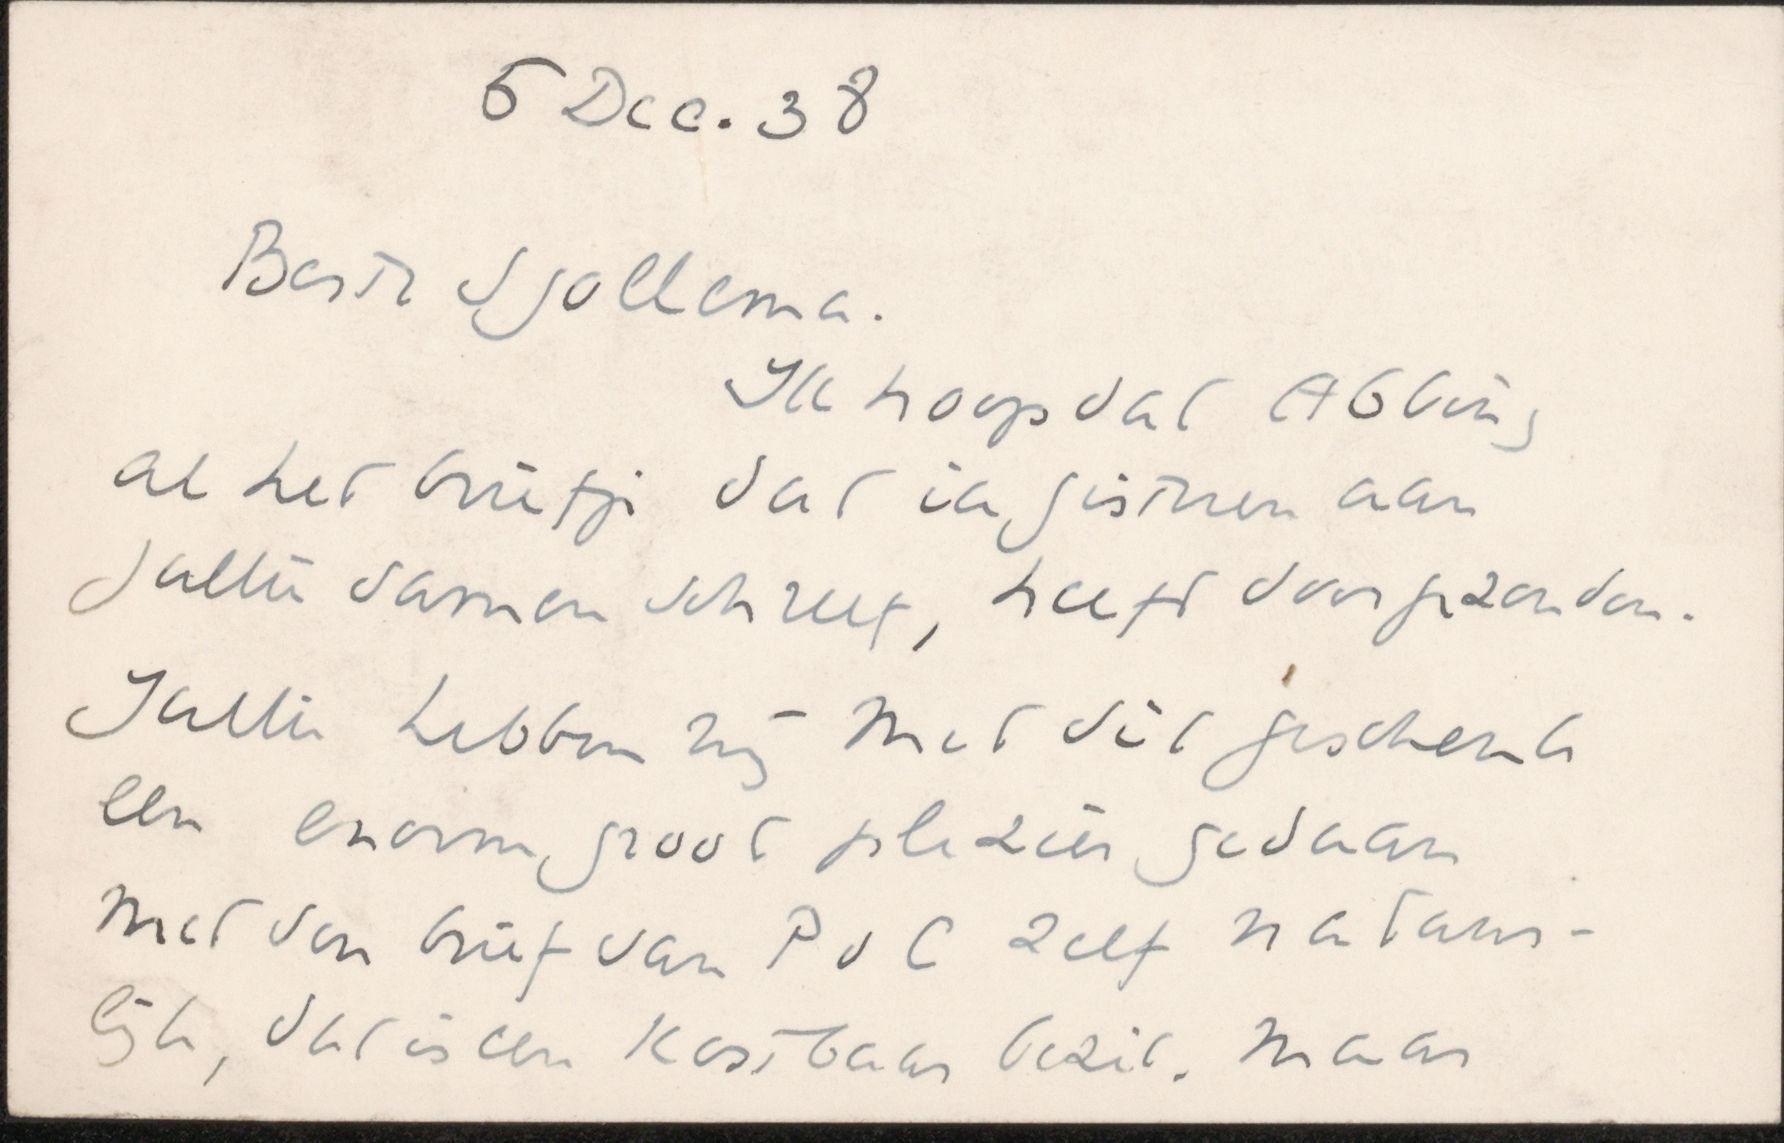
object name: letter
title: Brief aan Joop Sjollema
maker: richard nicolaüs roland holst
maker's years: 1868-1938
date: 1938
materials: cardboard, ink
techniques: pen, writing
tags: print maker, joop sjollema, amsterdam, draughtsman, fik abbing